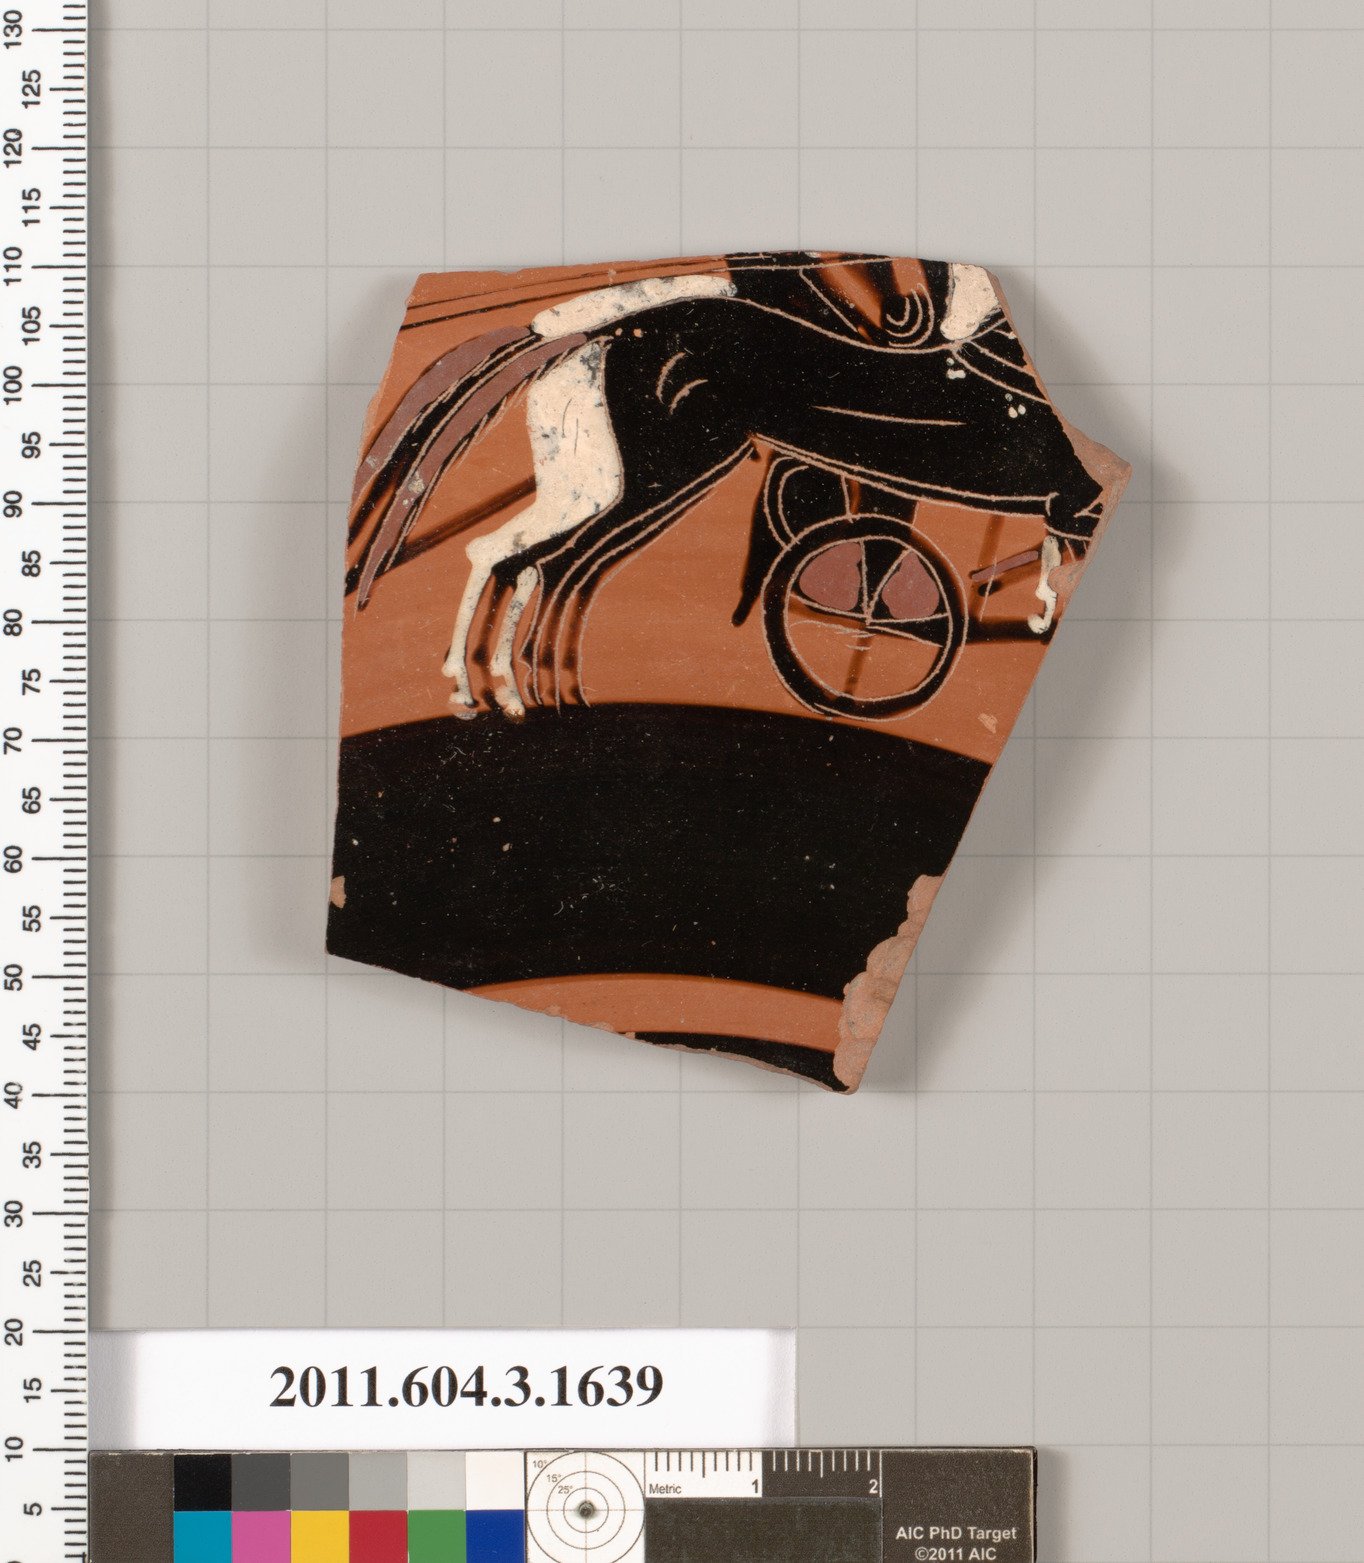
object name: kylix fragment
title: Terracotta fragment of a kylix: Band cup (drinking cup)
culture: greek, attic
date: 567-535 BCE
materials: terracotta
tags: horses